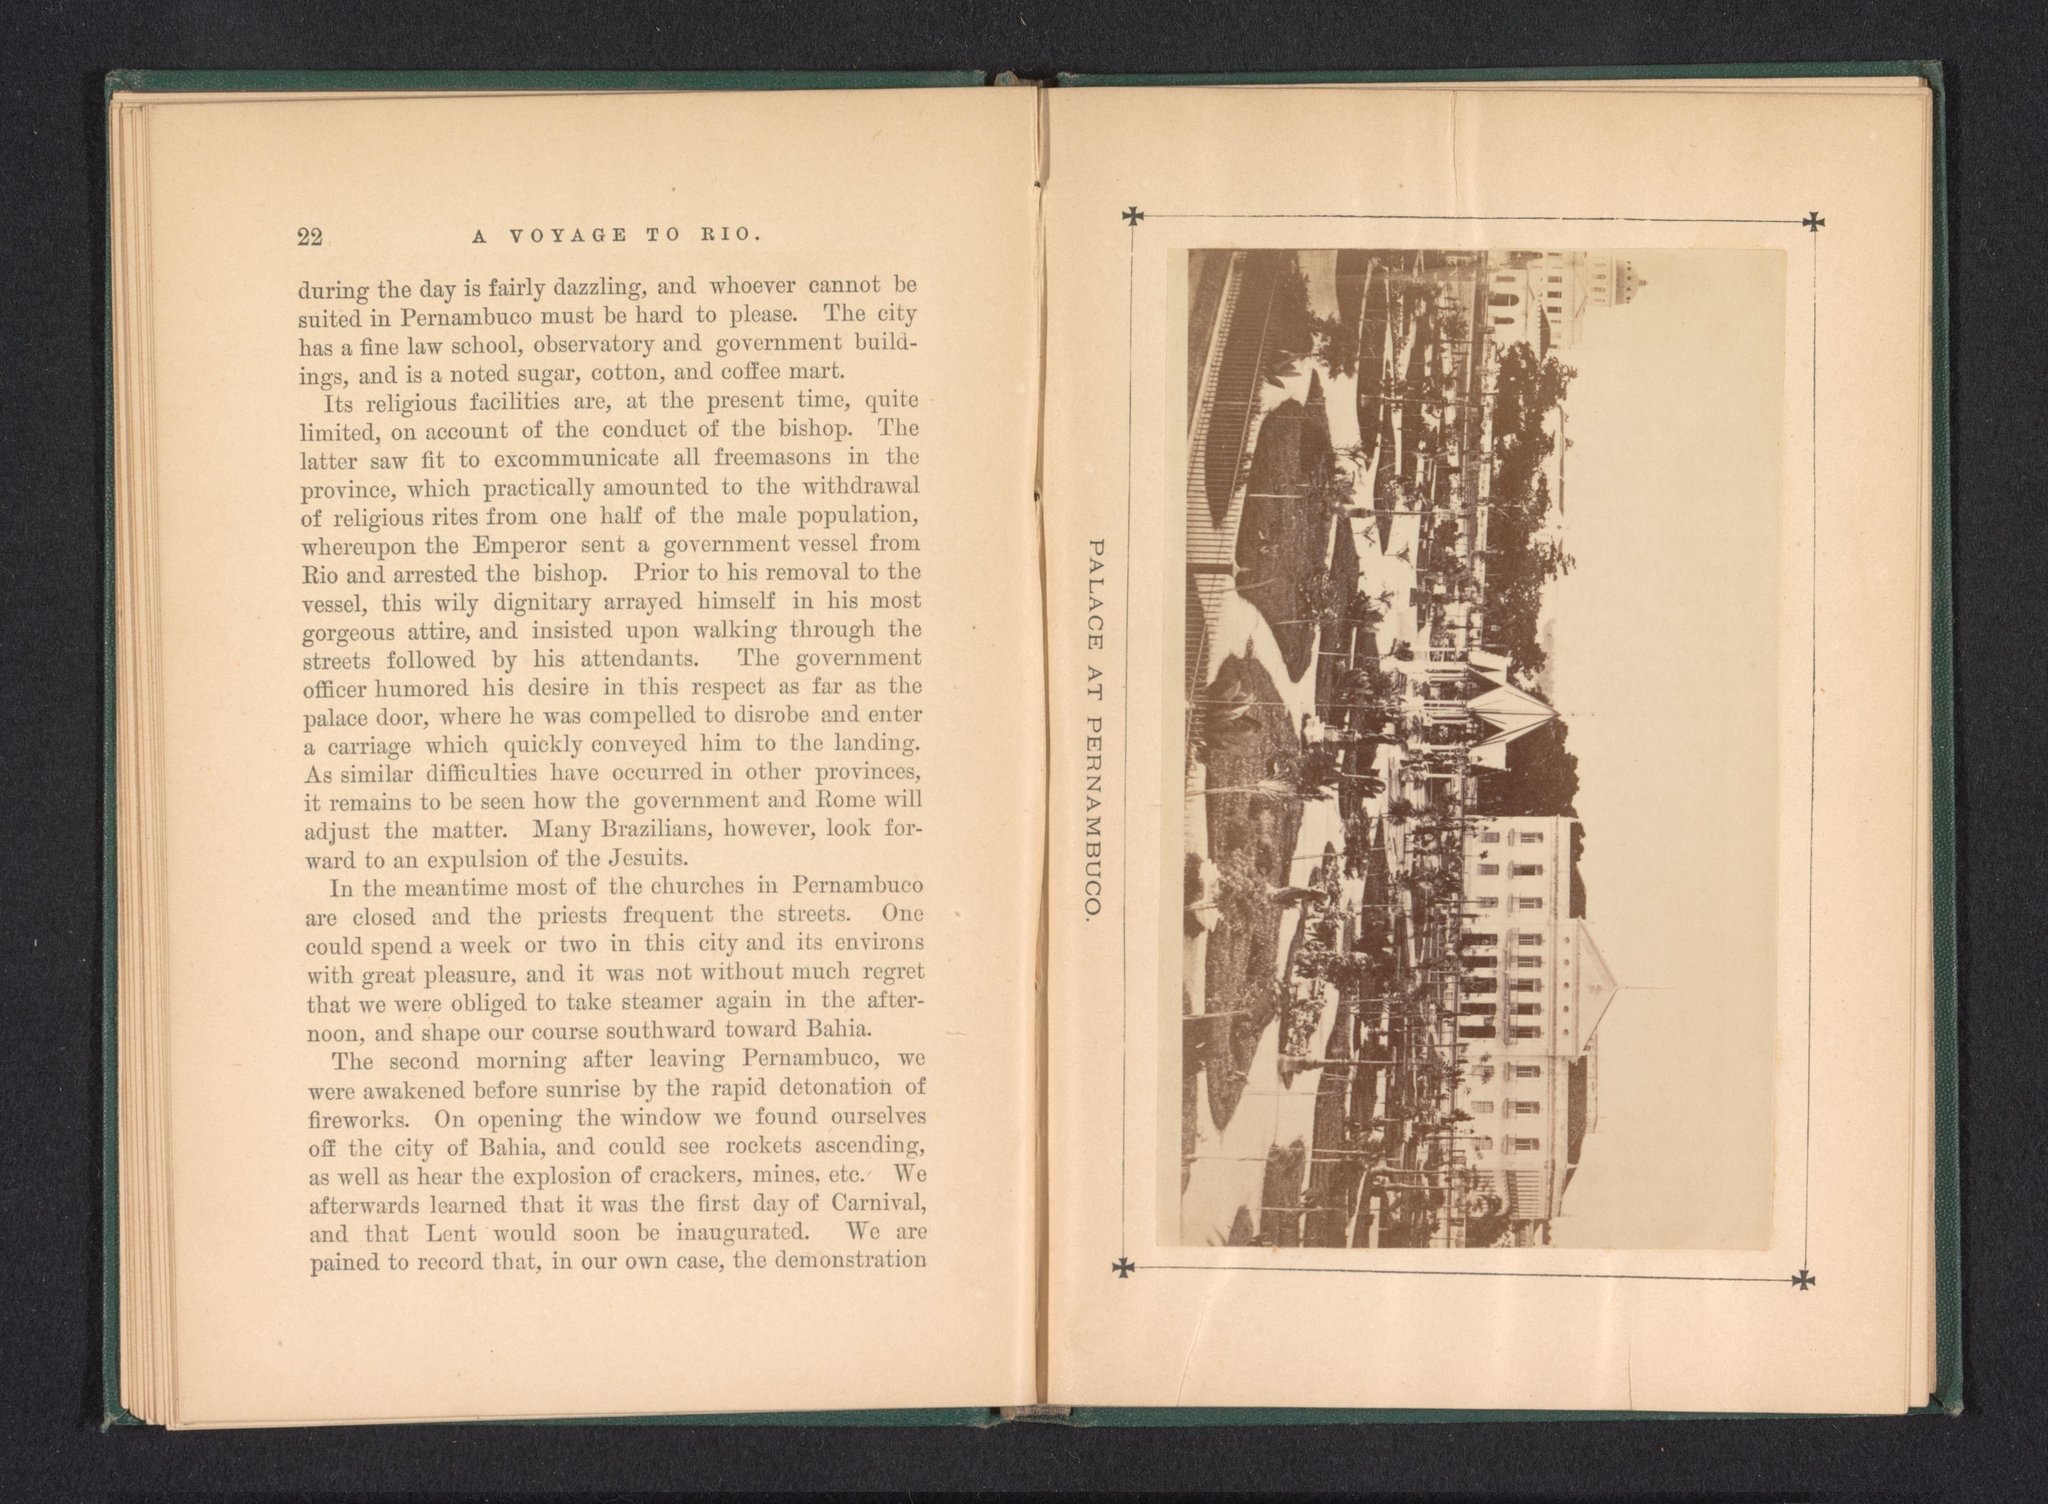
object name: page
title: Gezicht op een plein met een paleis in de staat Pernambuco in Brazilië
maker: Anonymous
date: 1864-1874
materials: photographic support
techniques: albumen print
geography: pernambuco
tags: square, place, circus, etc., palace